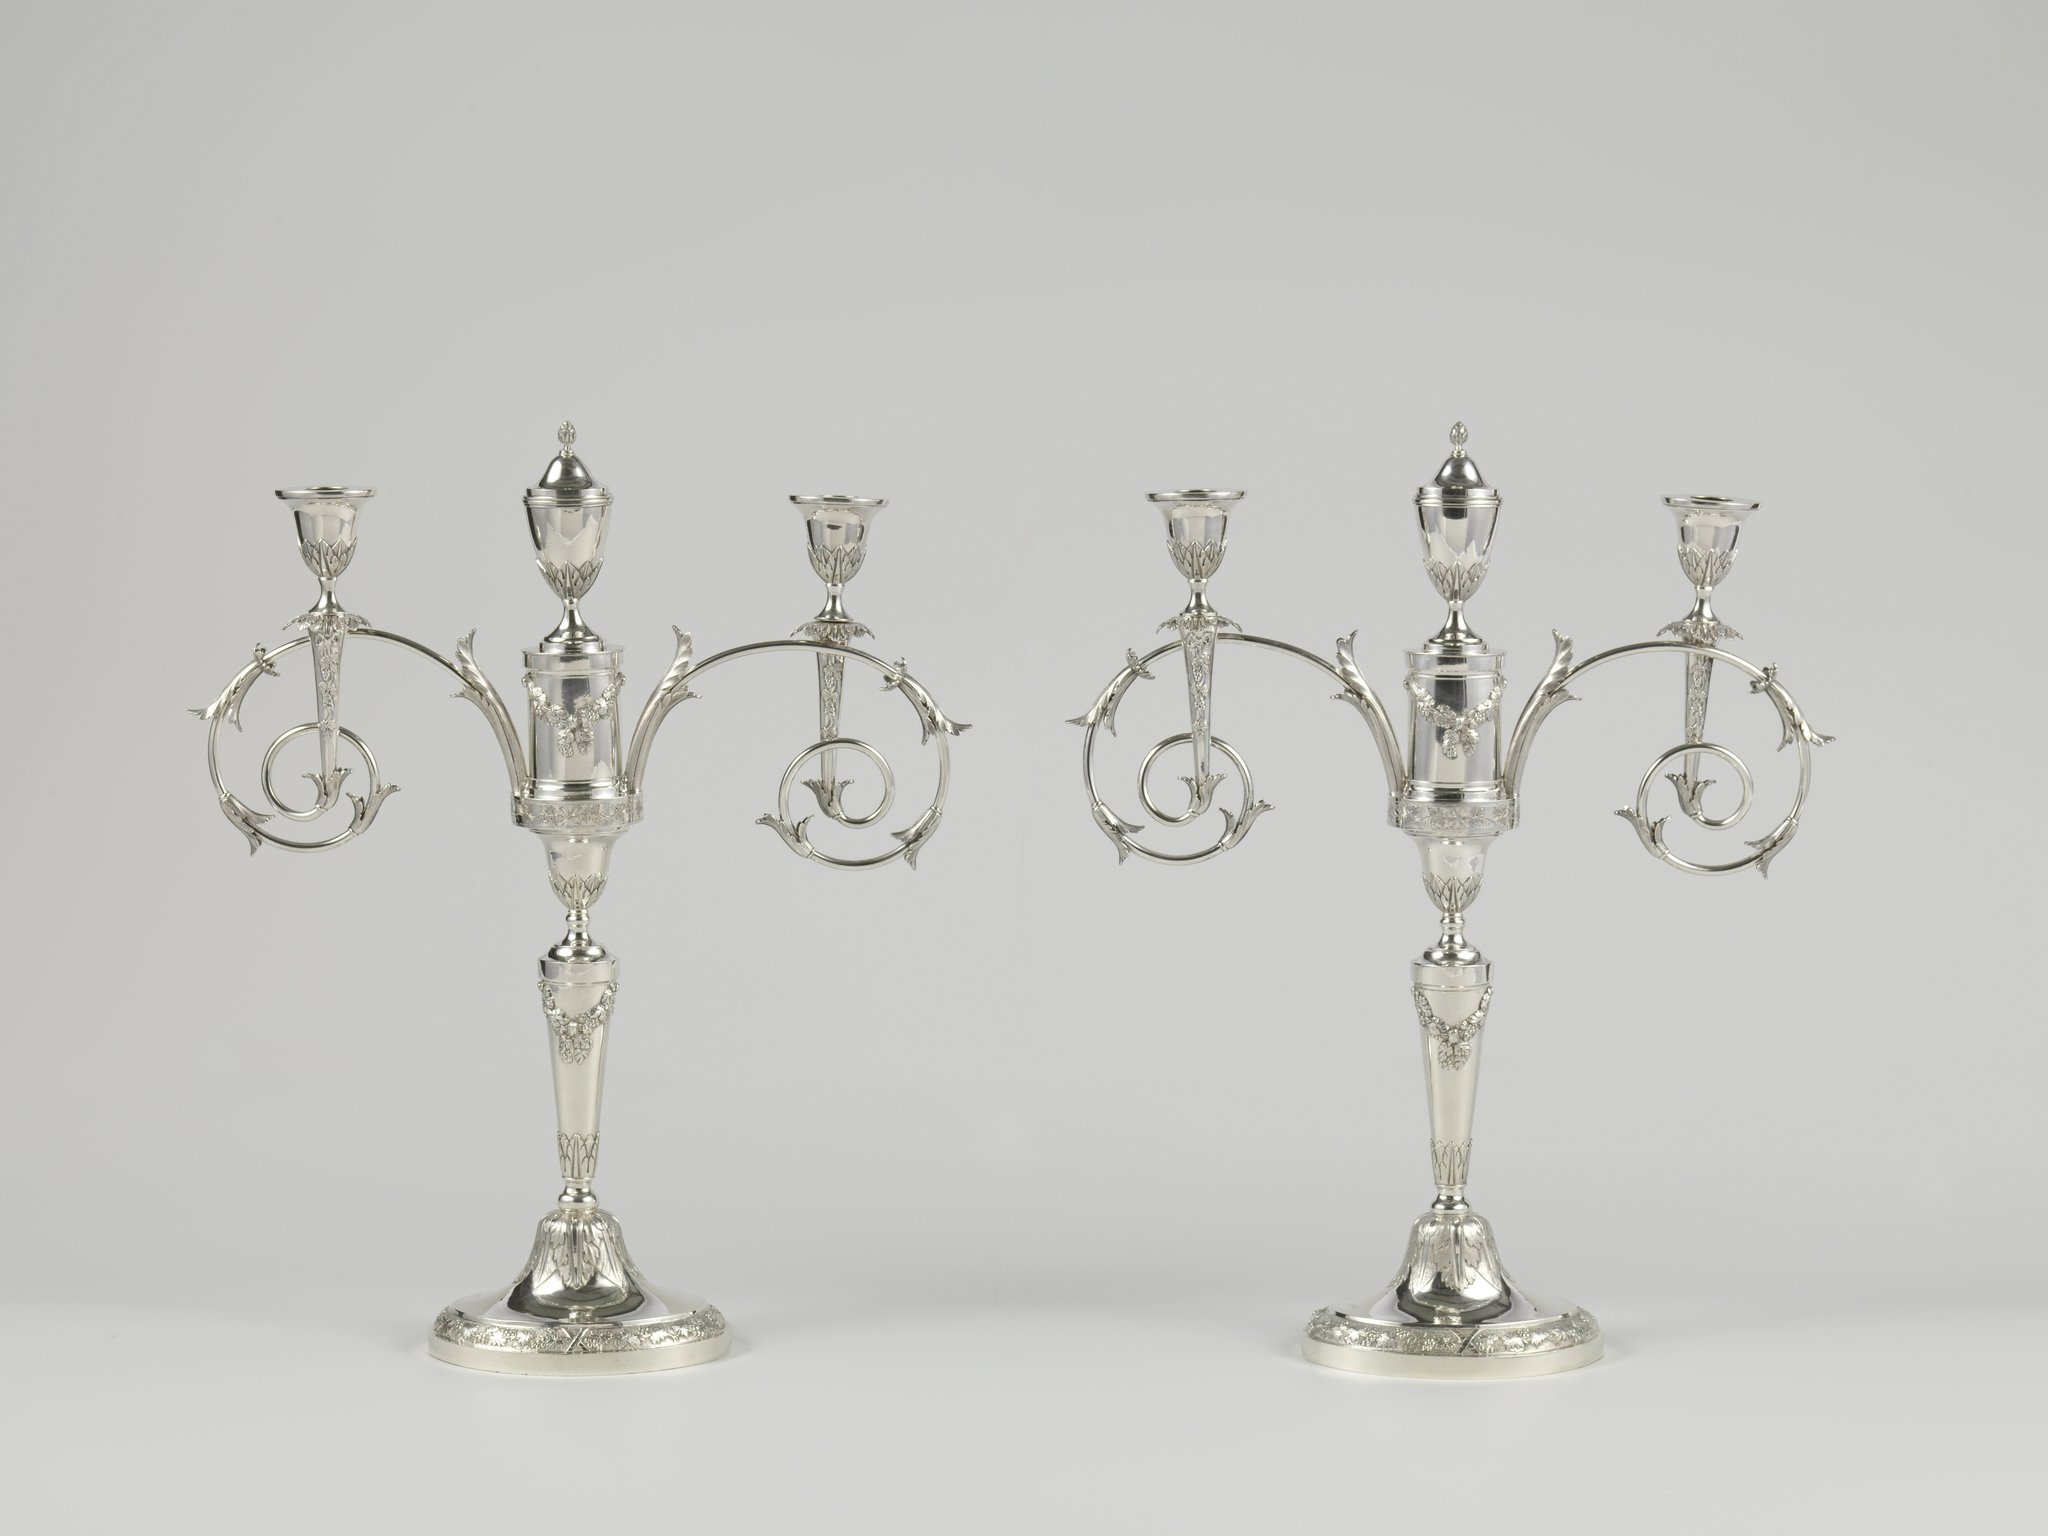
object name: candlestick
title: Kandelaar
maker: francois marcus simons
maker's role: silversmith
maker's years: 1750-1828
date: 1803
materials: silver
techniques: casting, metalworking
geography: the hague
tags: foliage, tendrils, branches ~ ornament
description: Dinner service. Silver, parcel gilt. The Hague, 1803 and 1804, by François Simons. The Government of the Batavian Republic presented this service to I.J.A. Gogel (1765 - 1821) in 1804 in recognition of his financial services to the country. Gogel was a prominent patriot, minister of finance under King Louis Napoleon and subsequently financial advisor to King